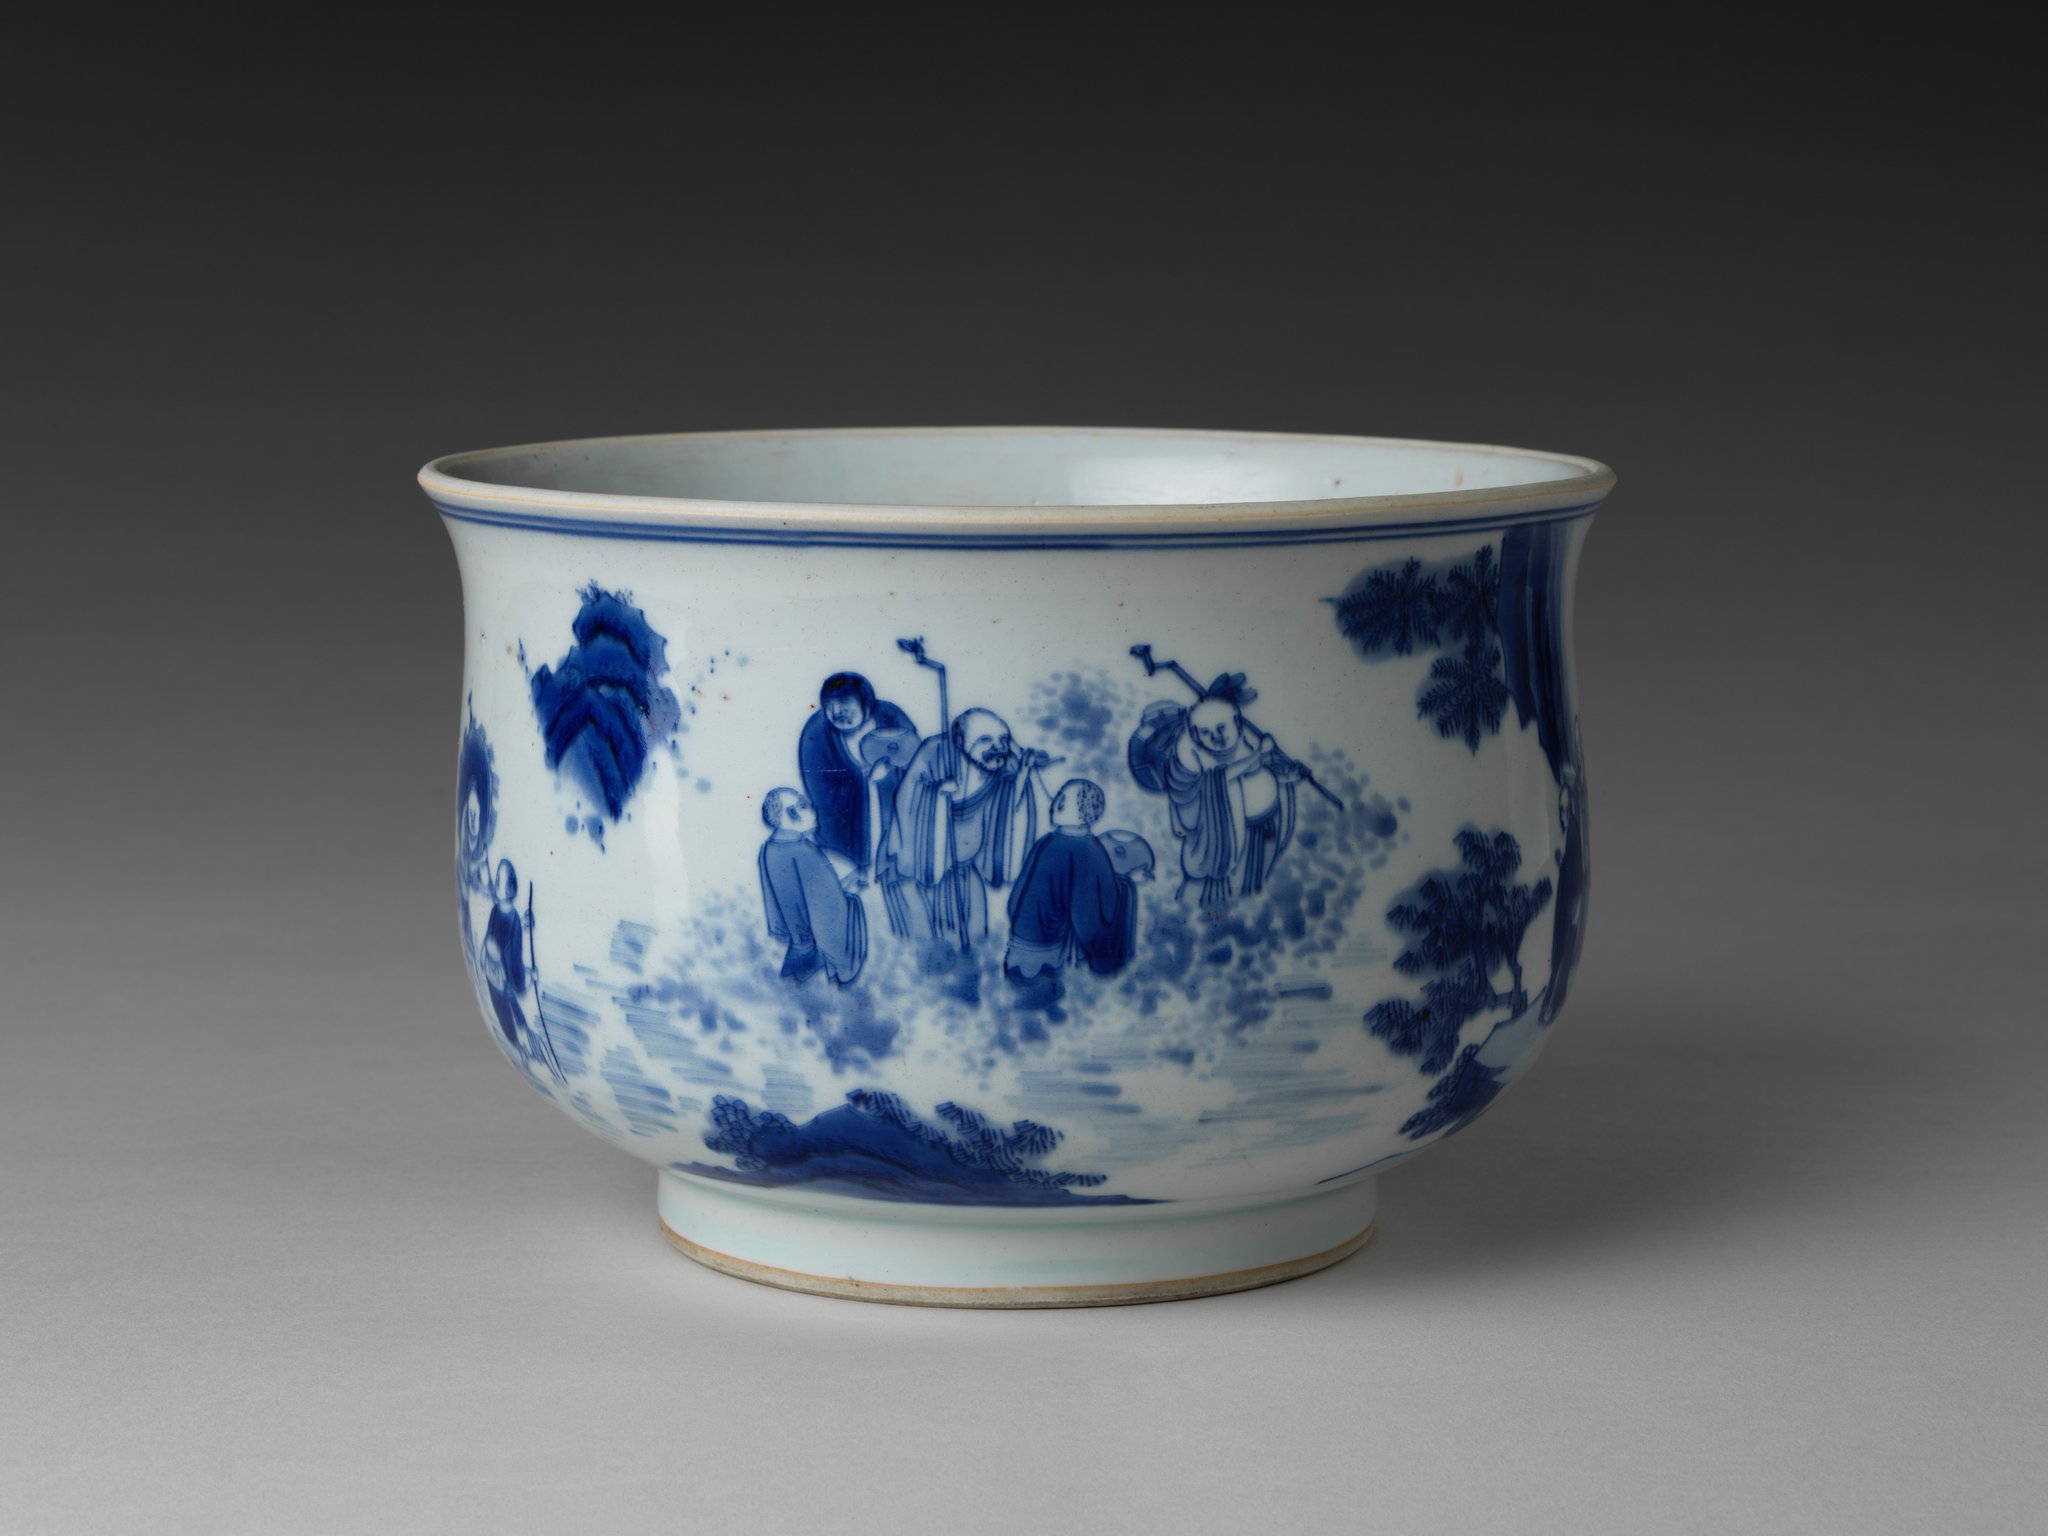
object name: incense burner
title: Incense Burner with the Eighteen Luohans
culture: chinese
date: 1645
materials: cobalt, porcelain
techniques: underglaze